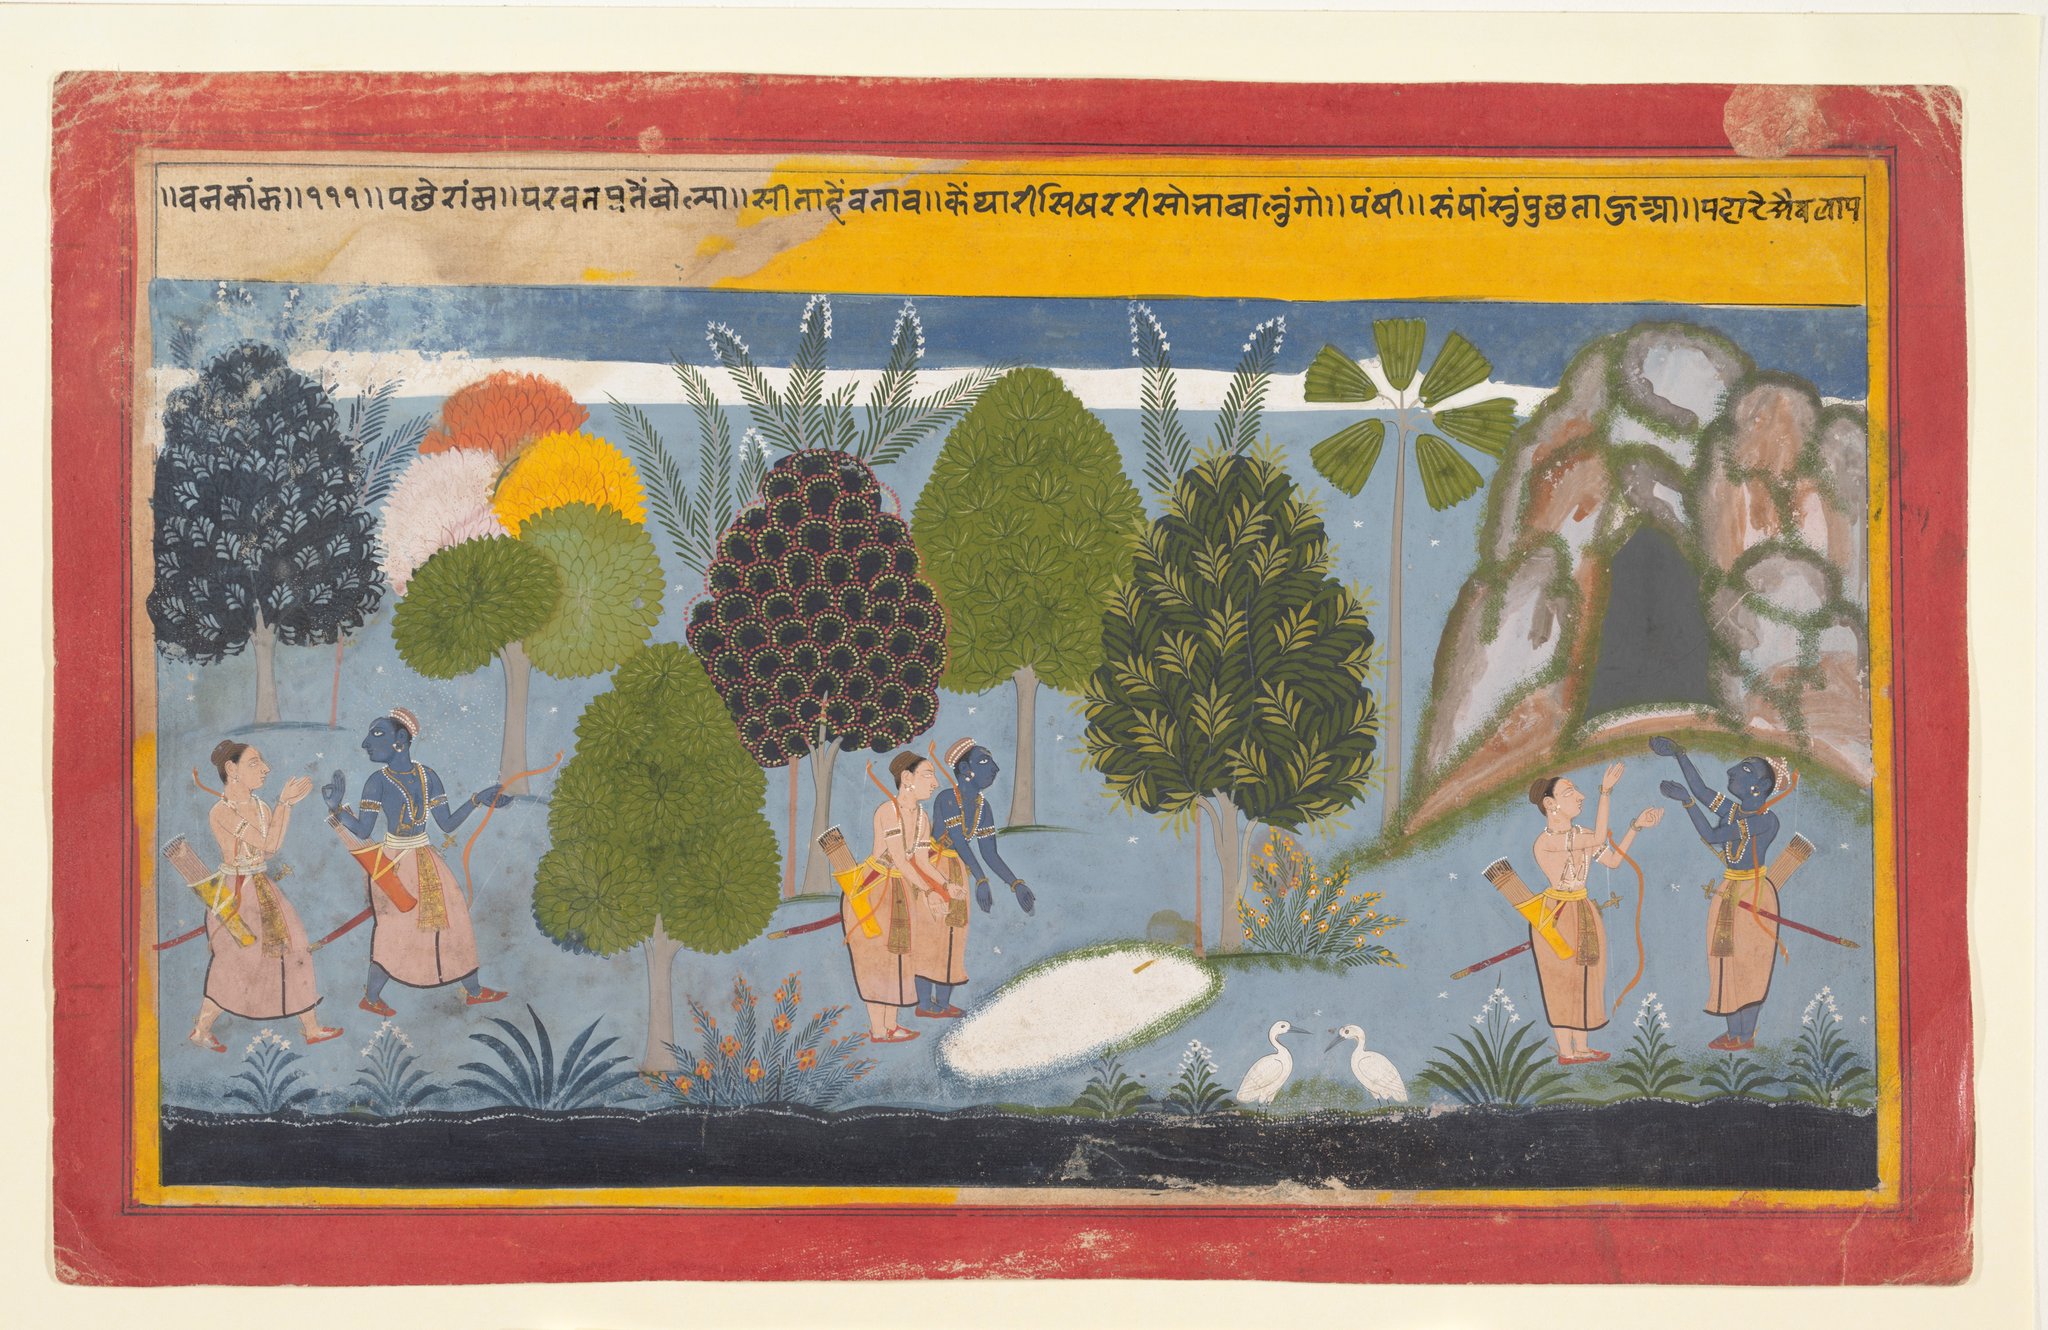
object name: folio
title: Rama and Lakshmana Search in Vain for Sita: Illustrated folio from a dispersed Ramayana series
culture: indian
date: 1680-1690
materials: ink, paper, watercolor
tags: birds,bow and arrow,men,trees